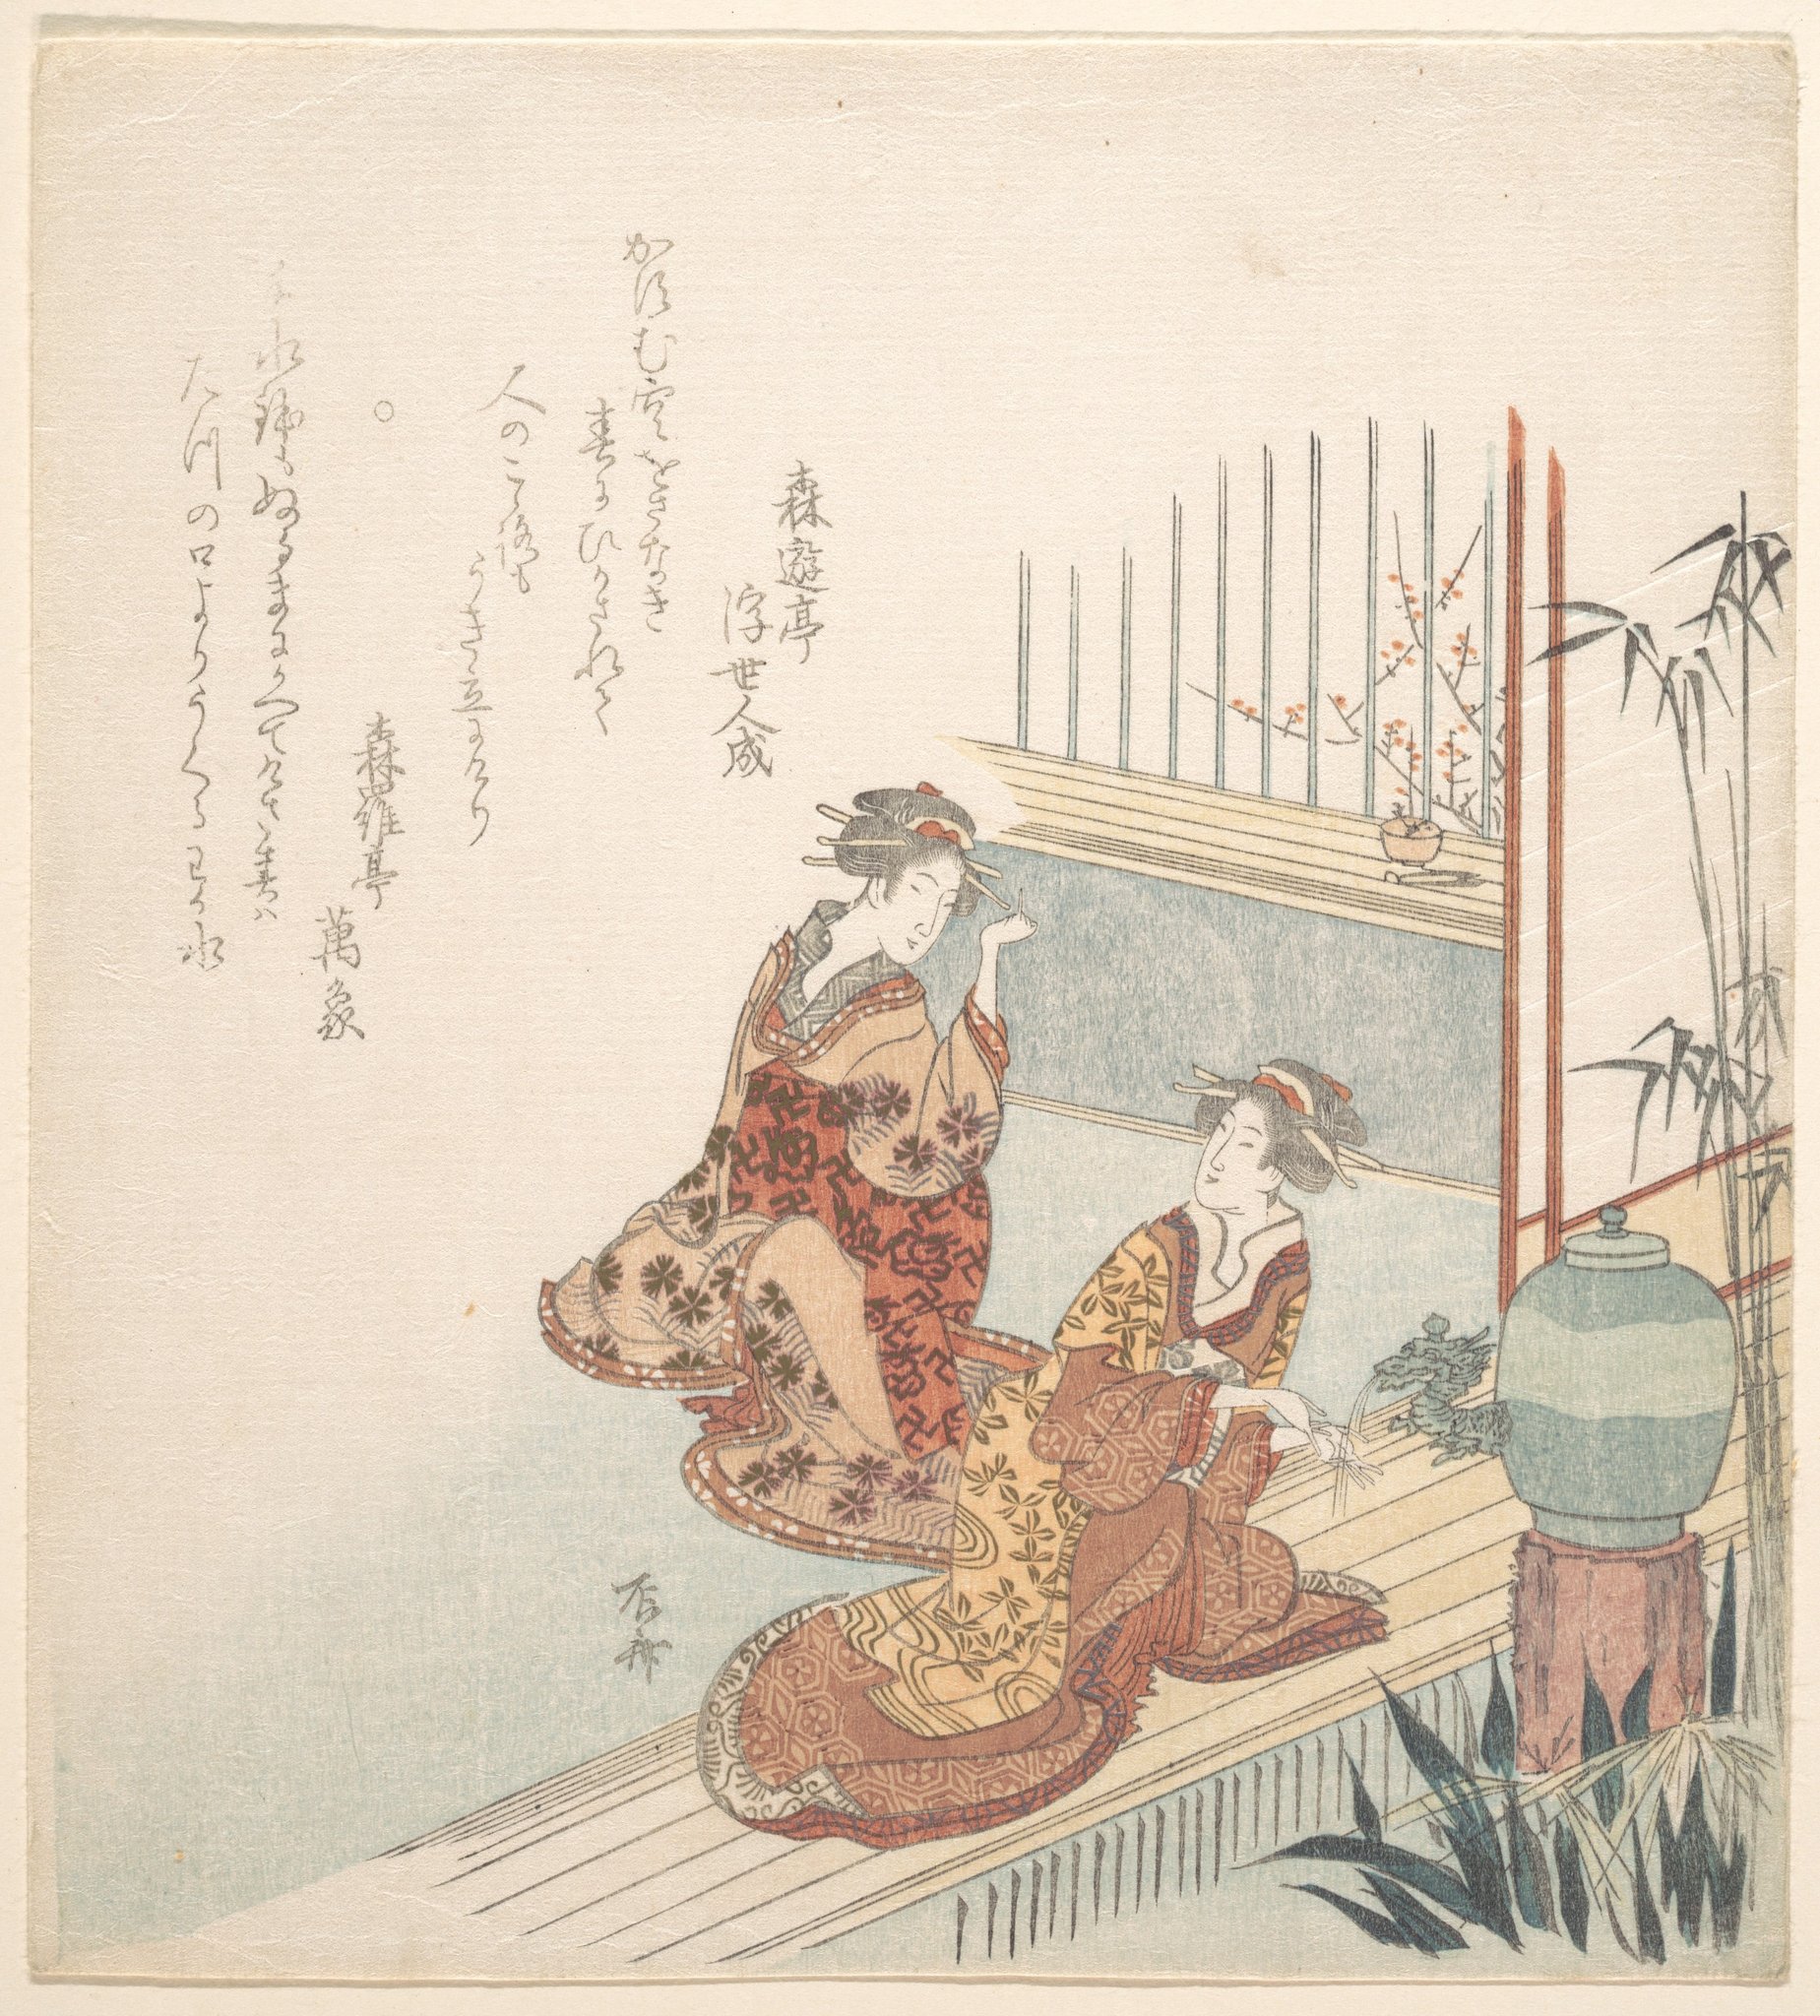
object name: print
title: Early Spring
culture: japanese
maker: ryūryūkyo shinsai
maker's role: artist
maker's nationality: japanese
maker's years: 1799-1823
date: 1750-1835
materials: ink, paper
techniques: surimono, woodblock print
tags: women,plants